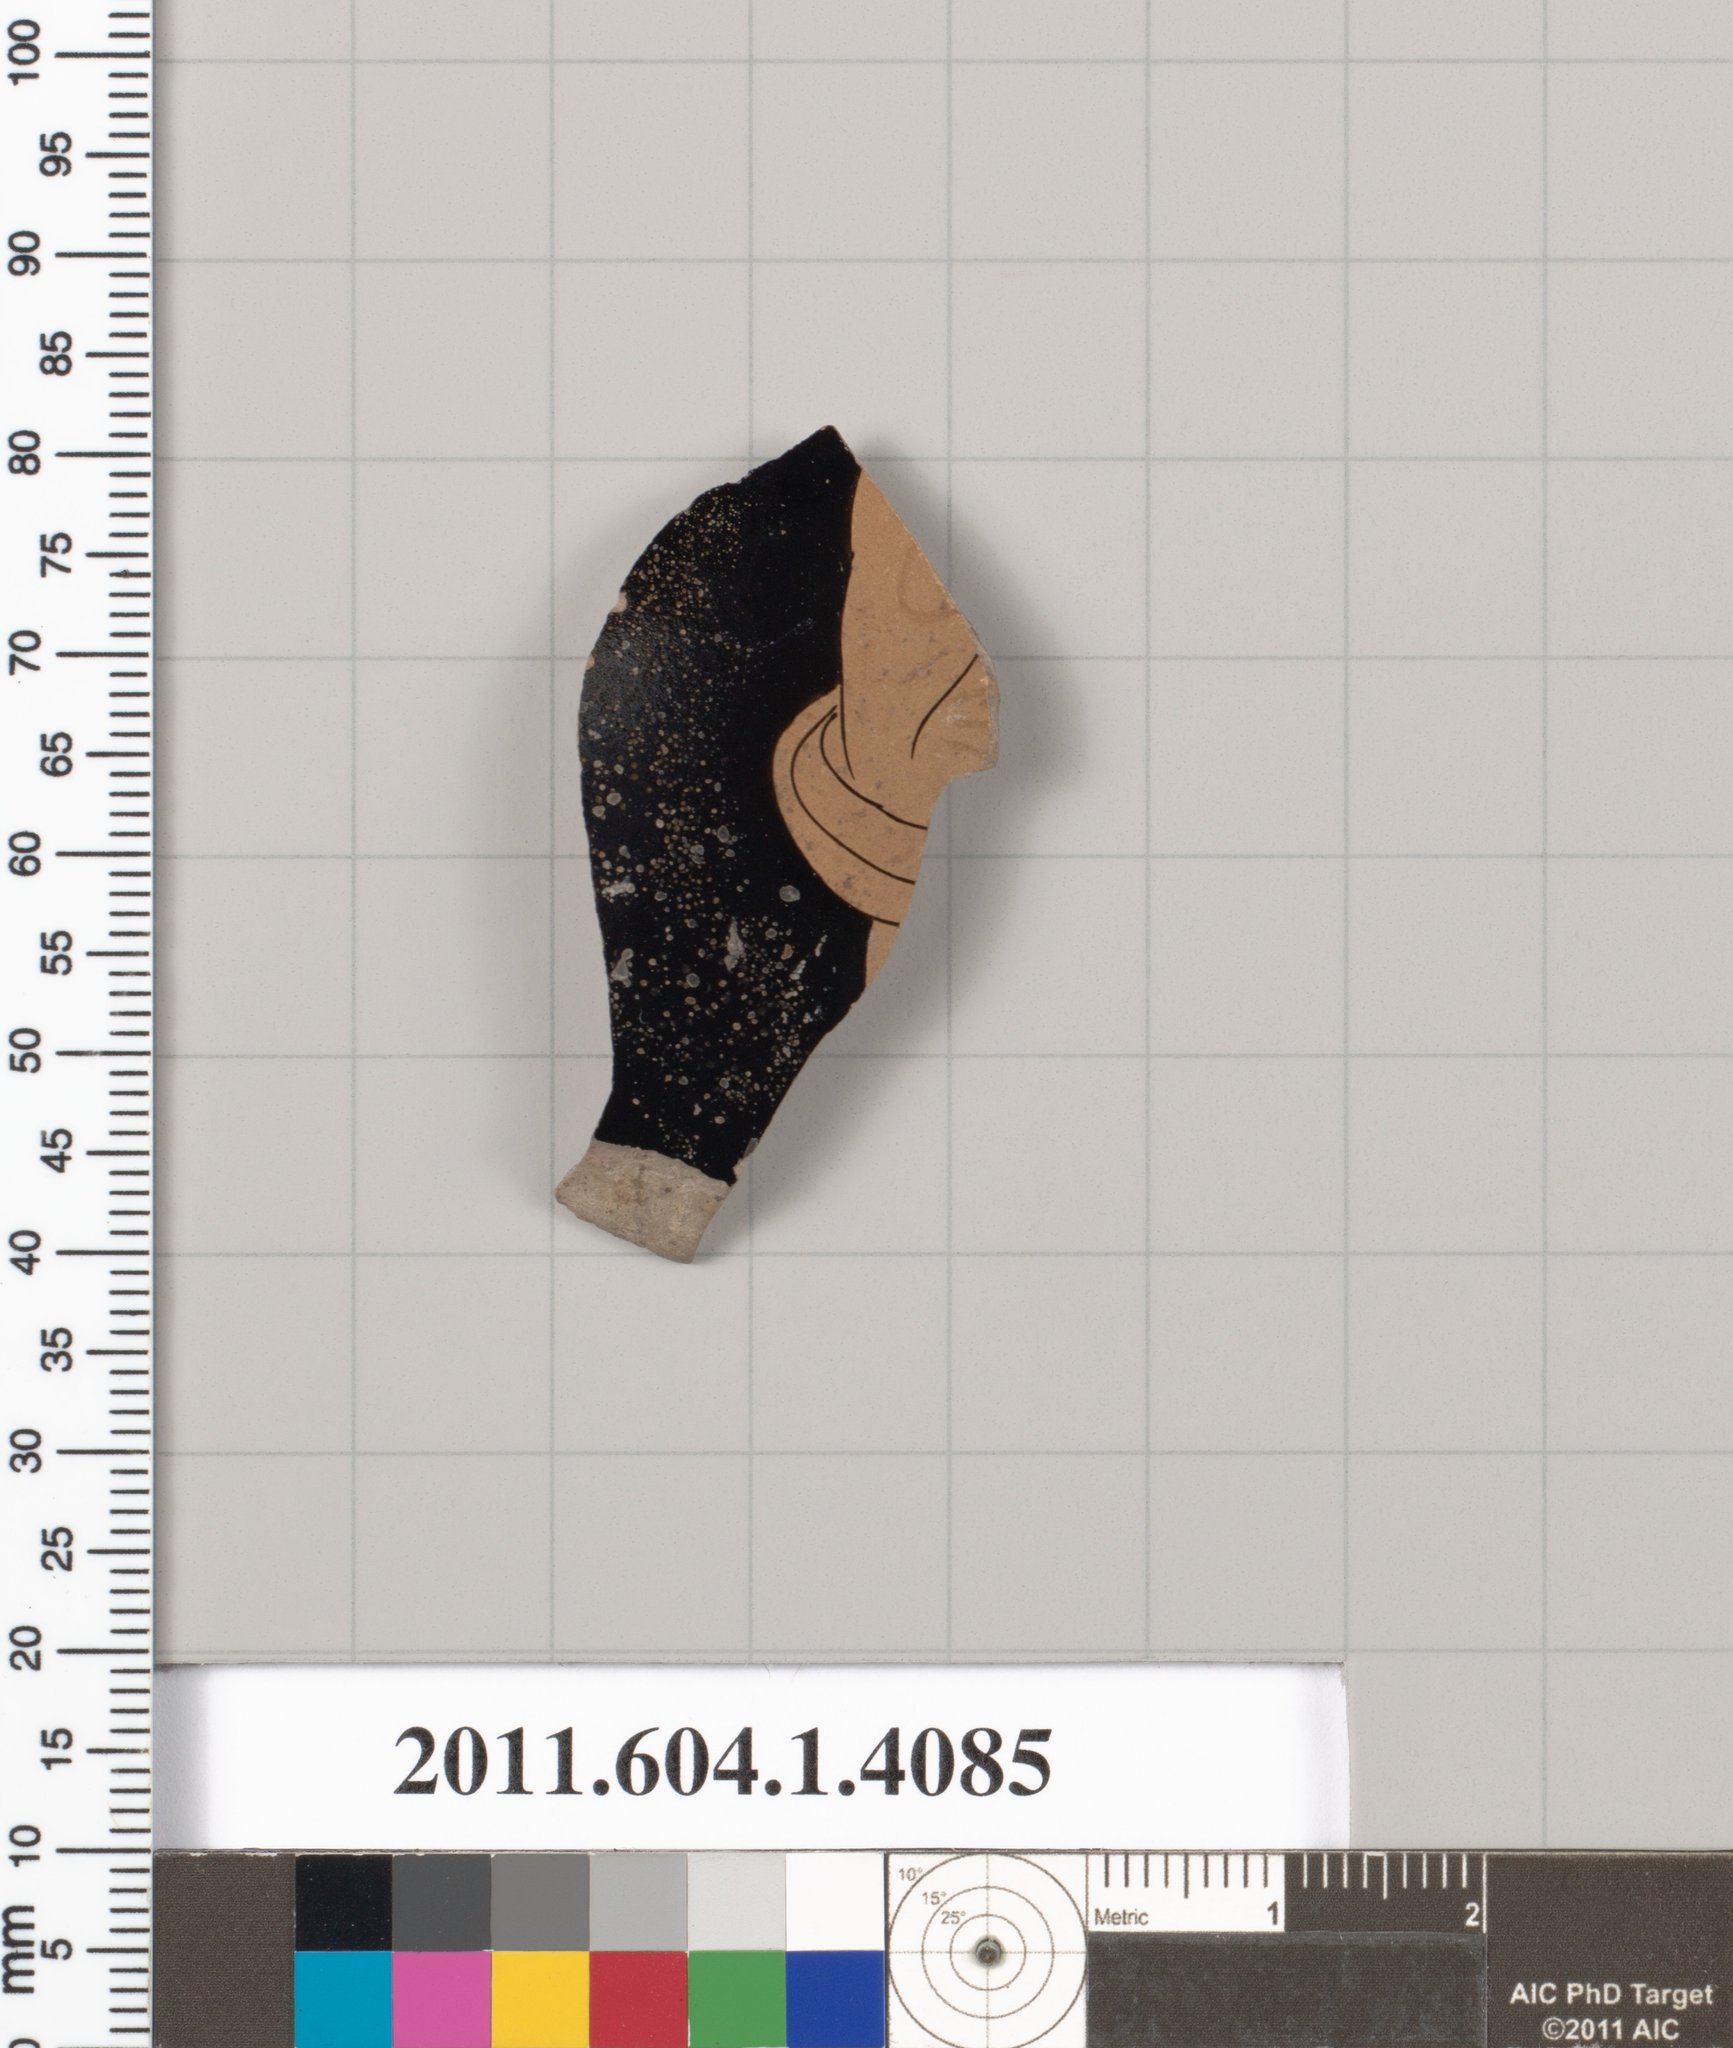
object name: kylix fragment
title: Terracotta fragment of a kylix (drinking cup)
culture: greek, attic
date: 500-480 BCE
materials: terracotta